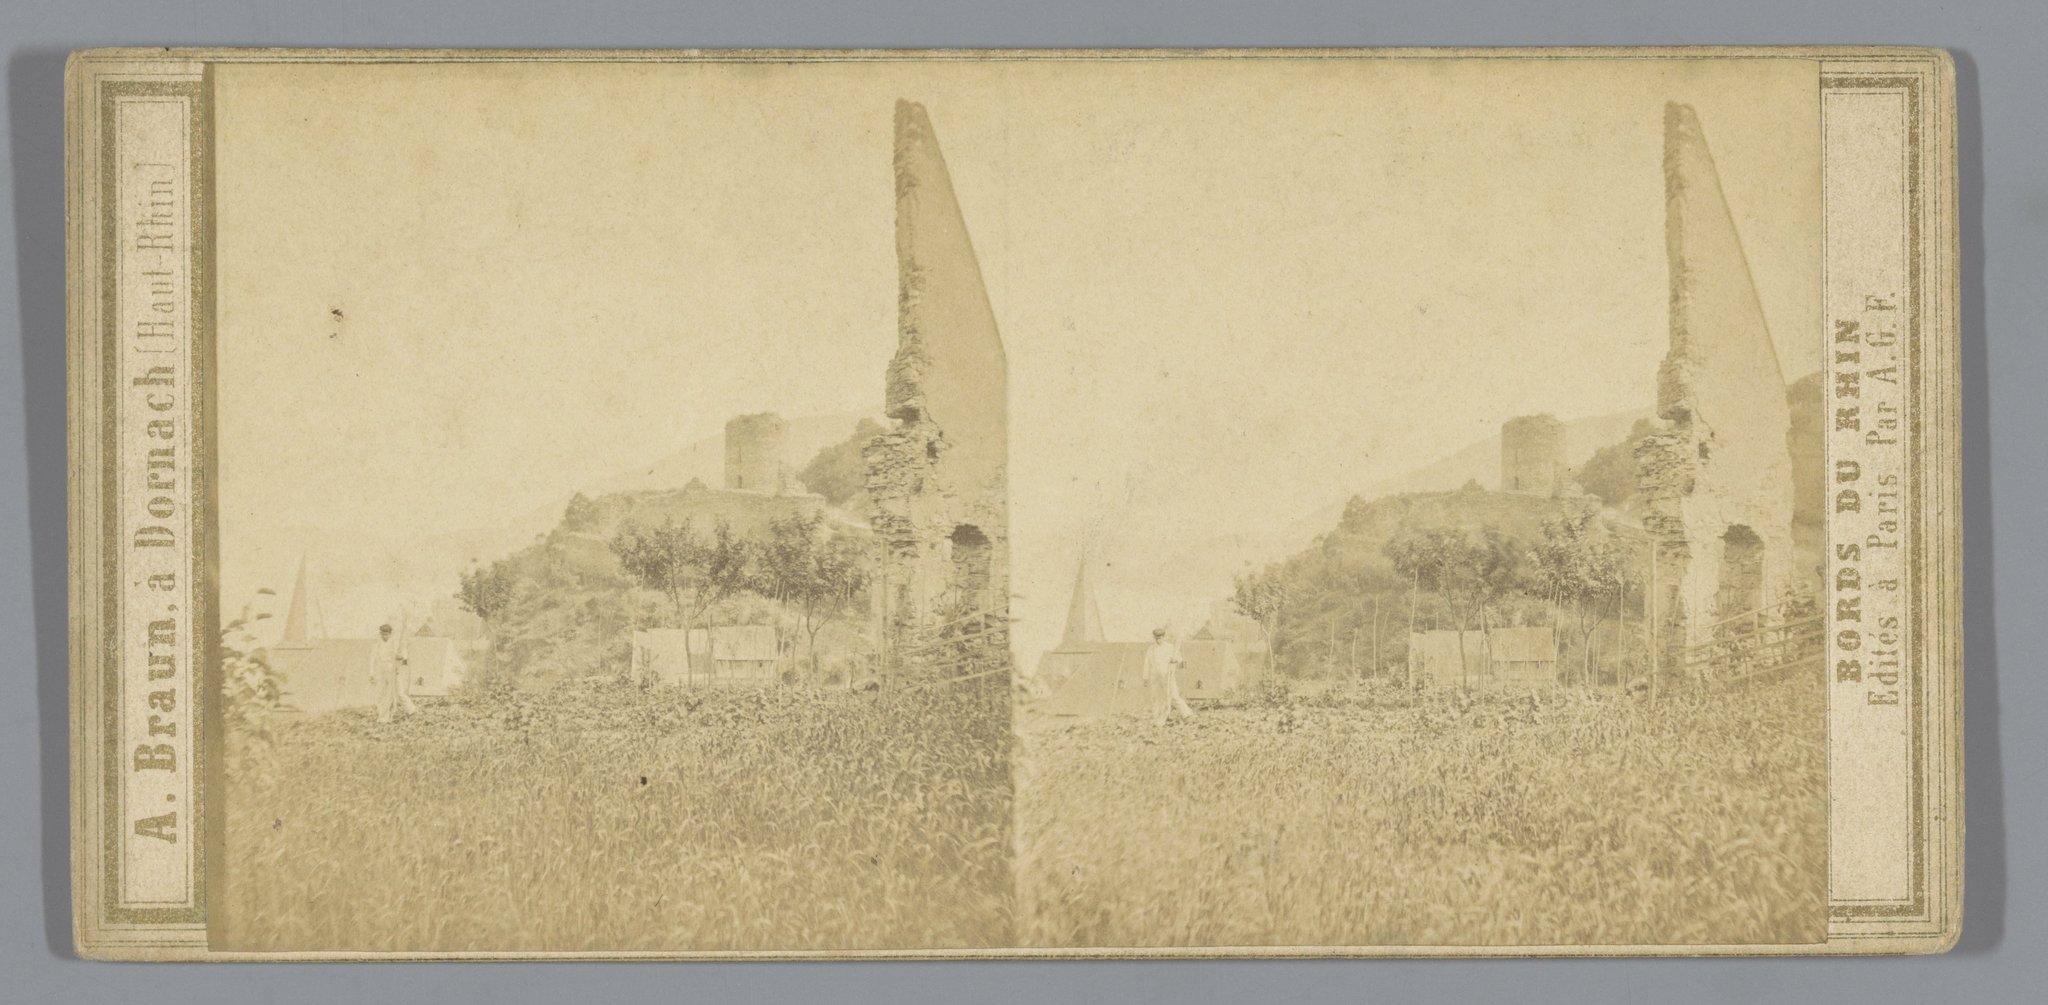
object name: stereograph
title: Gezicht op de Heimburg, Duitsland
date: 1860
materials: cardboard, paper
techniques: albumen print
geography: heimburg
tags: ruin of a dwelling, house, castle, etc.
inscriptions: number: ‘870.’